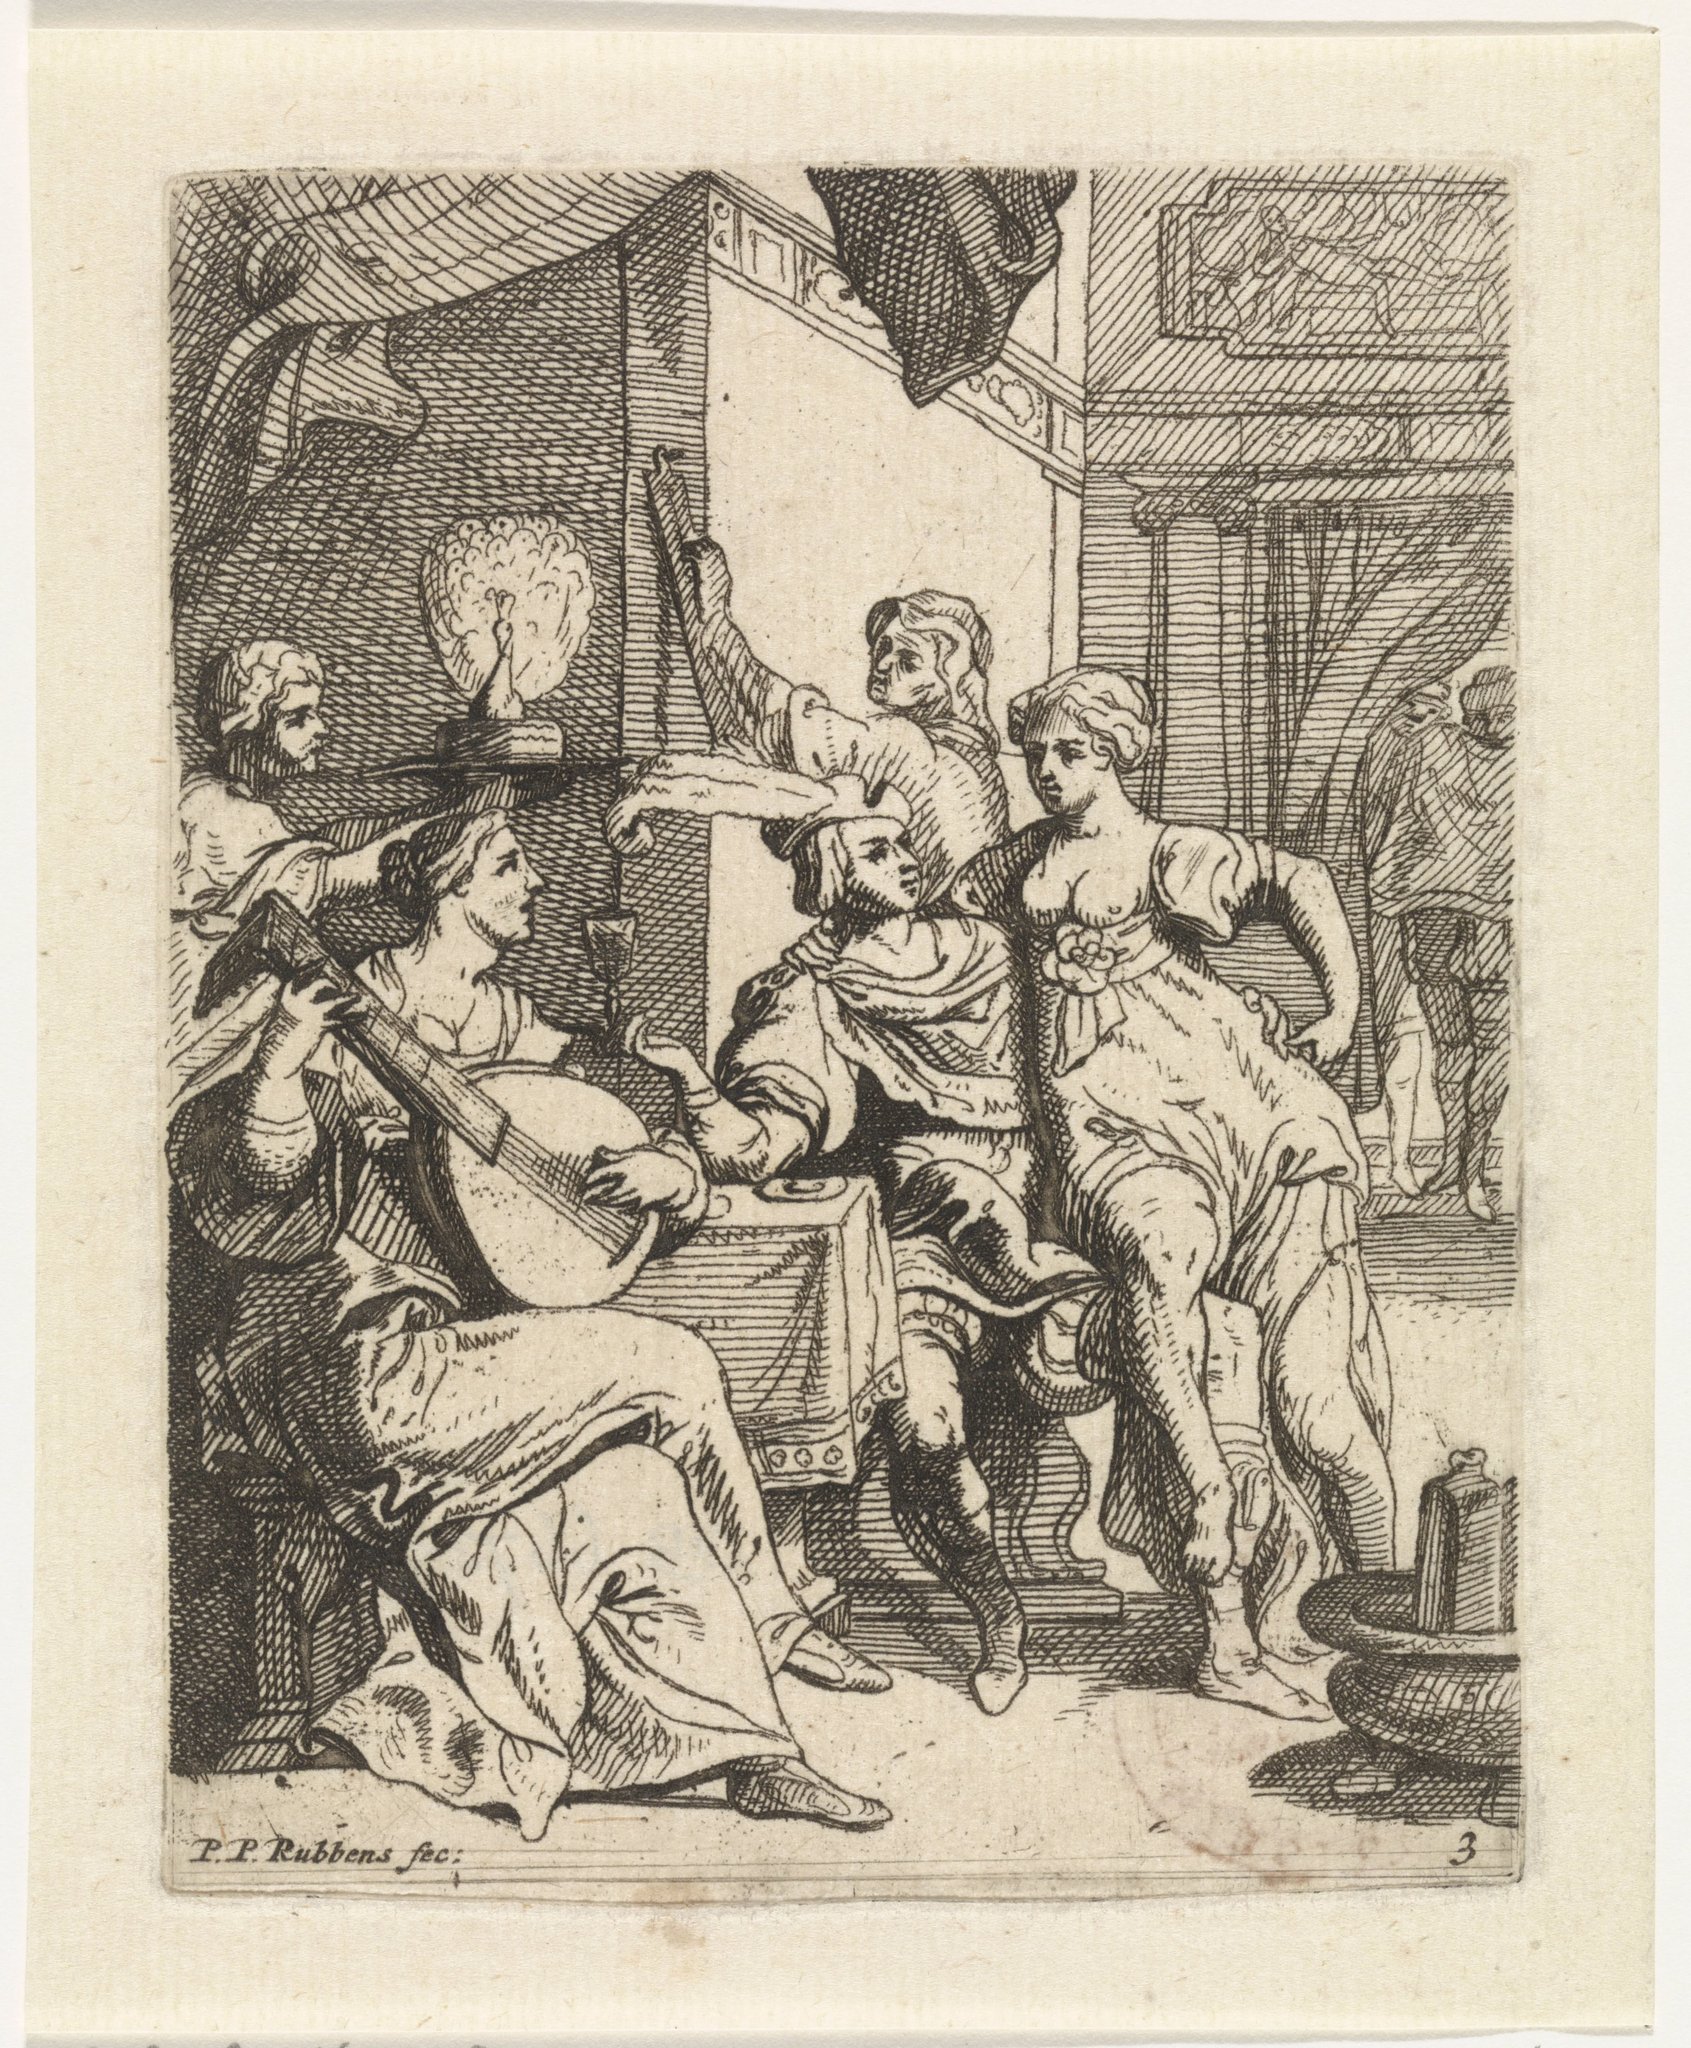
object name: print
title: De verloren zoon verkwist zijn geld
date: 1694-1737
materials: paper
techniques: etching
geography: amsterdam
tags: the prodigal son in the midst of prostitutes feasting and dissipating his patrimony, usually in a brothel or inn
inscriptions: collector's mark: Lugt 240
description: De verloren zoon verkwist zijn geld door een losbandig leven te leiden. Hij slaat zijn arm om de middel van een prostituee en houdt een glas wijn in de andere hand. Een vrouw bespeelt de luit en een man brengt een pastei binnen.